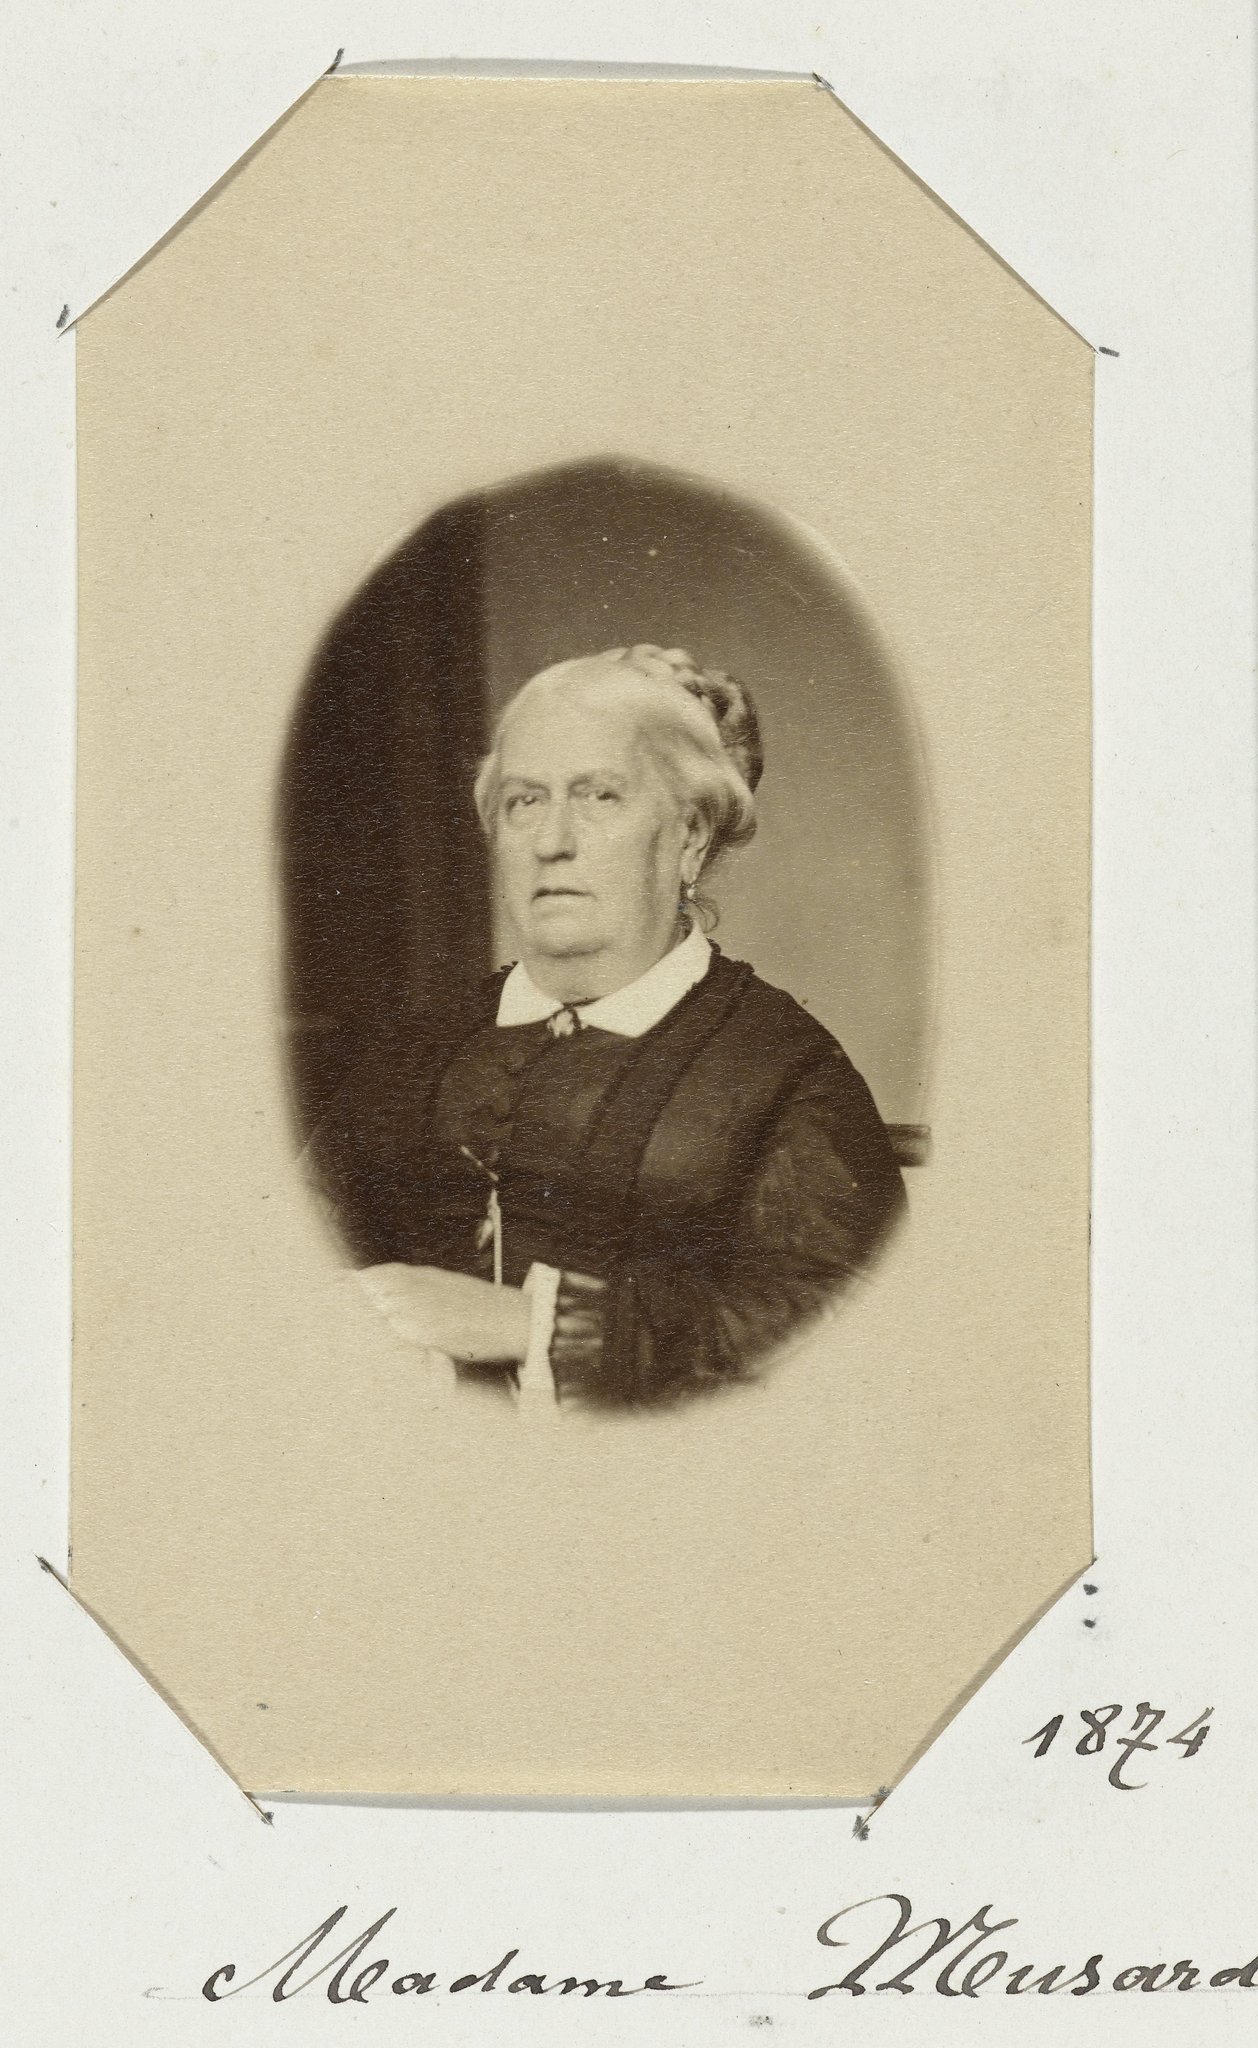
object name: photograph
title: Madame Meusard mère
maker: Anonymous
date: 1874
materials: paper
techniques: albumen print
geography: france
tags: historical persons - bb - woman, old woman, france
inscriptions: number: ‘74’, inscription: ‘Madame Meusard mère 1874’